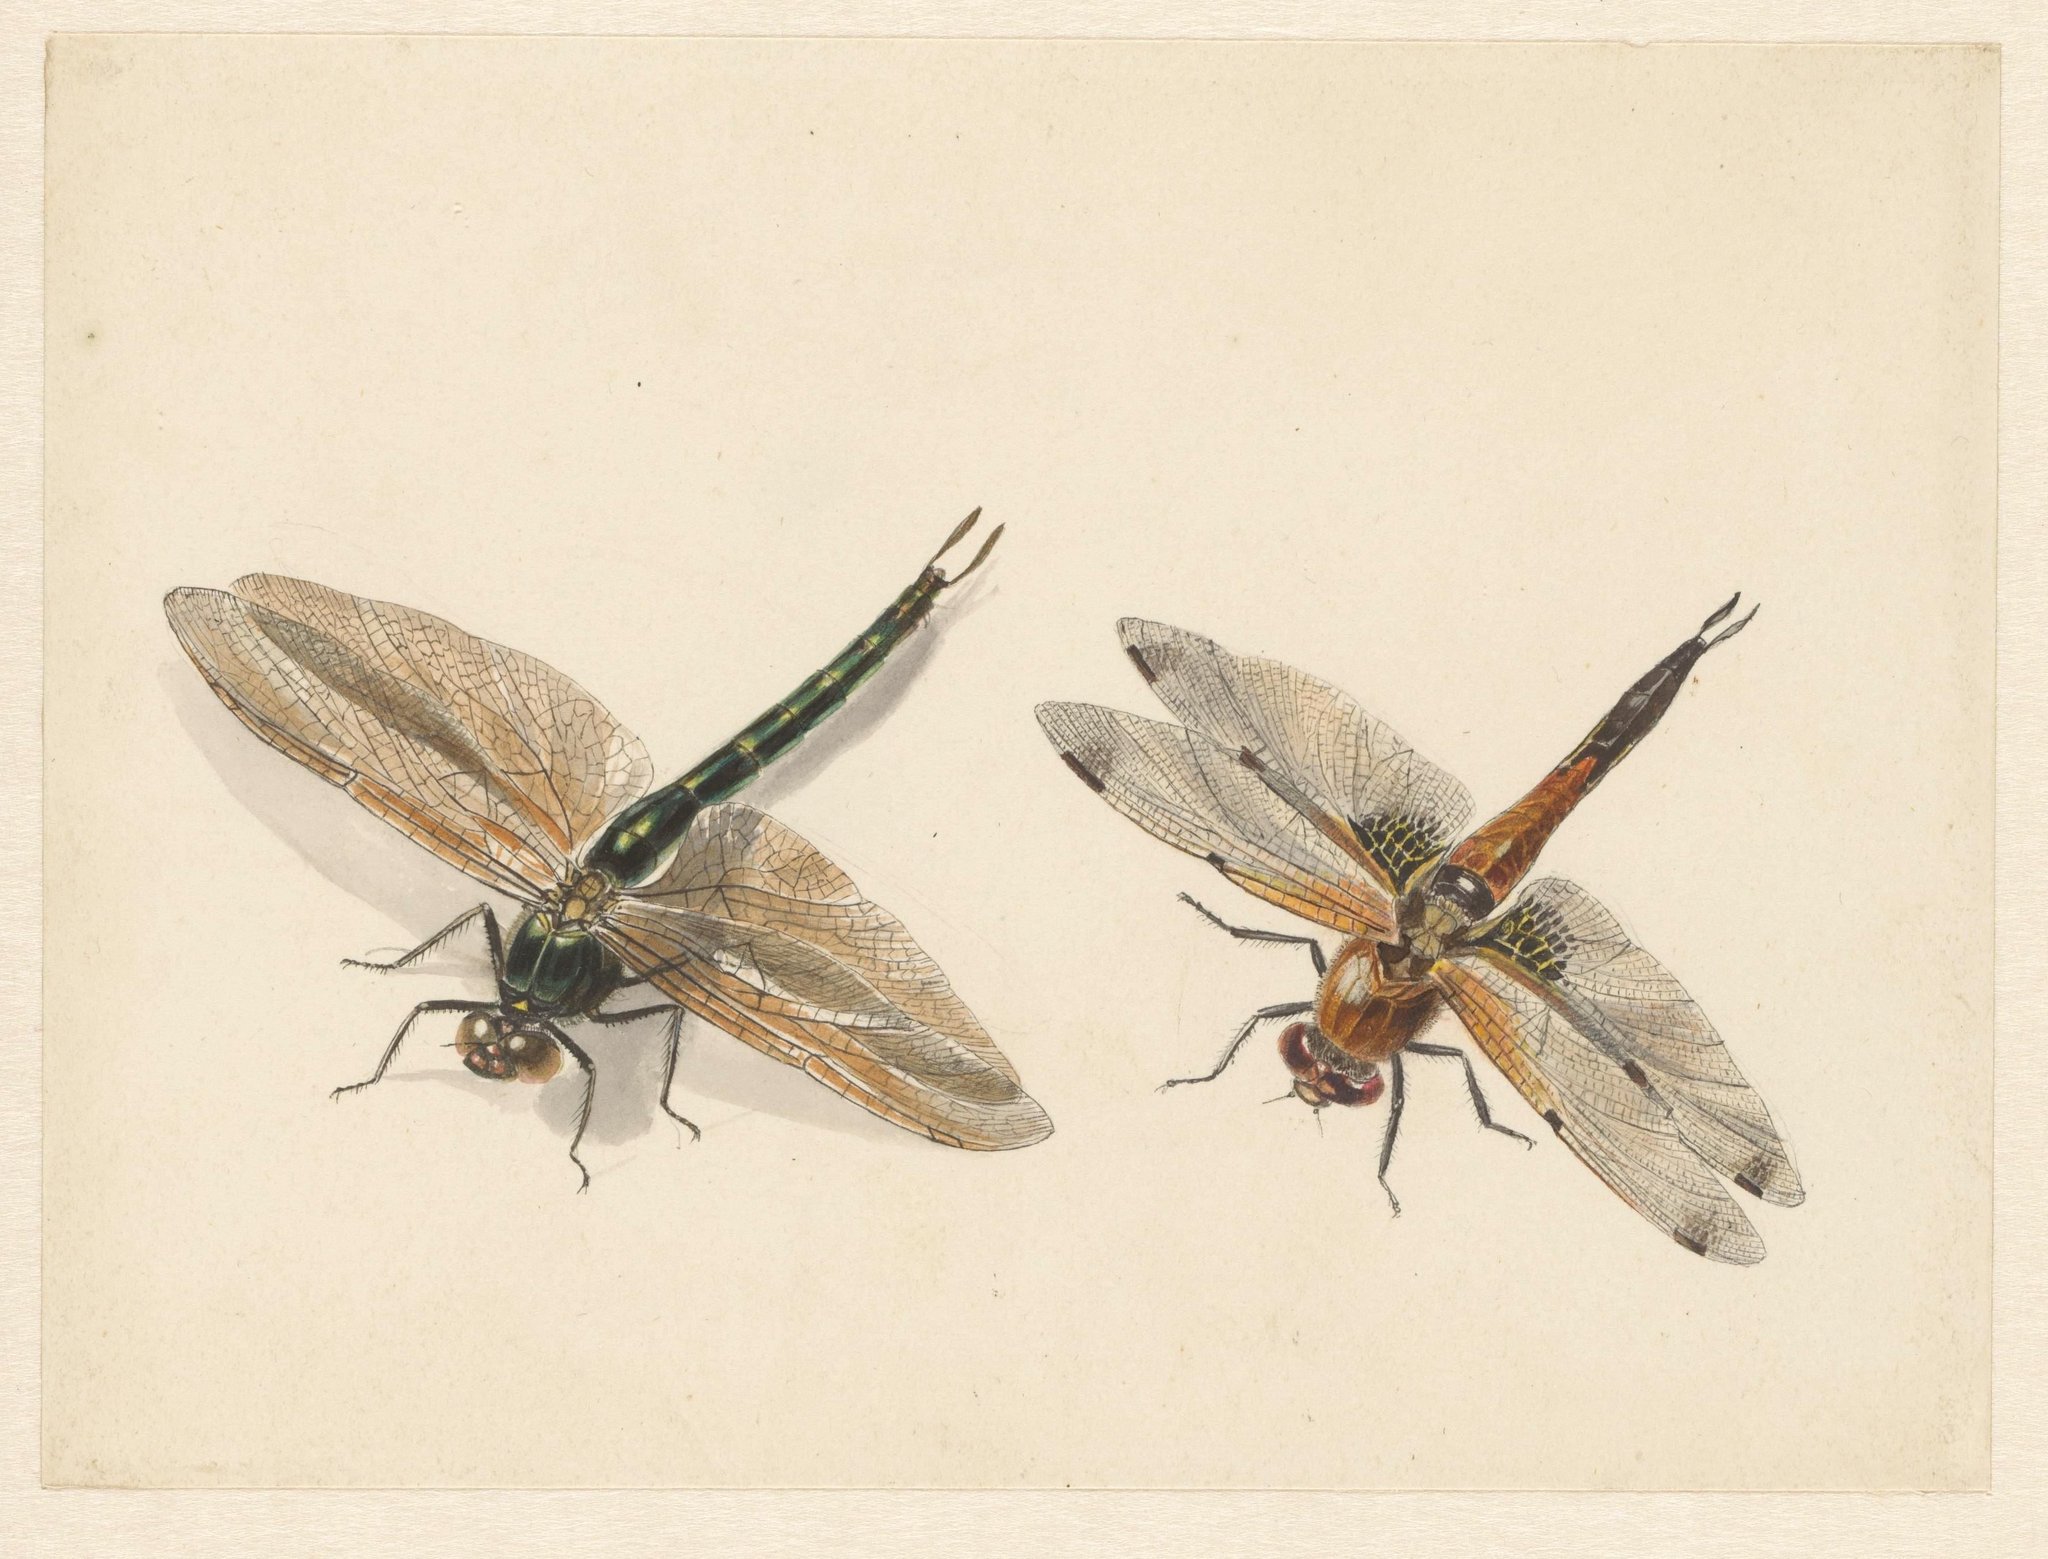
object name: drawing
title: Studie van twee libellen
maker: albertus steenbergen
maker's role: draughtsman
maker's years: 1814-1900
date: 1824-1900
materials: ink, paper, pencil, watercolor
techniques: brush, pen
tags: insects: dragon-fly